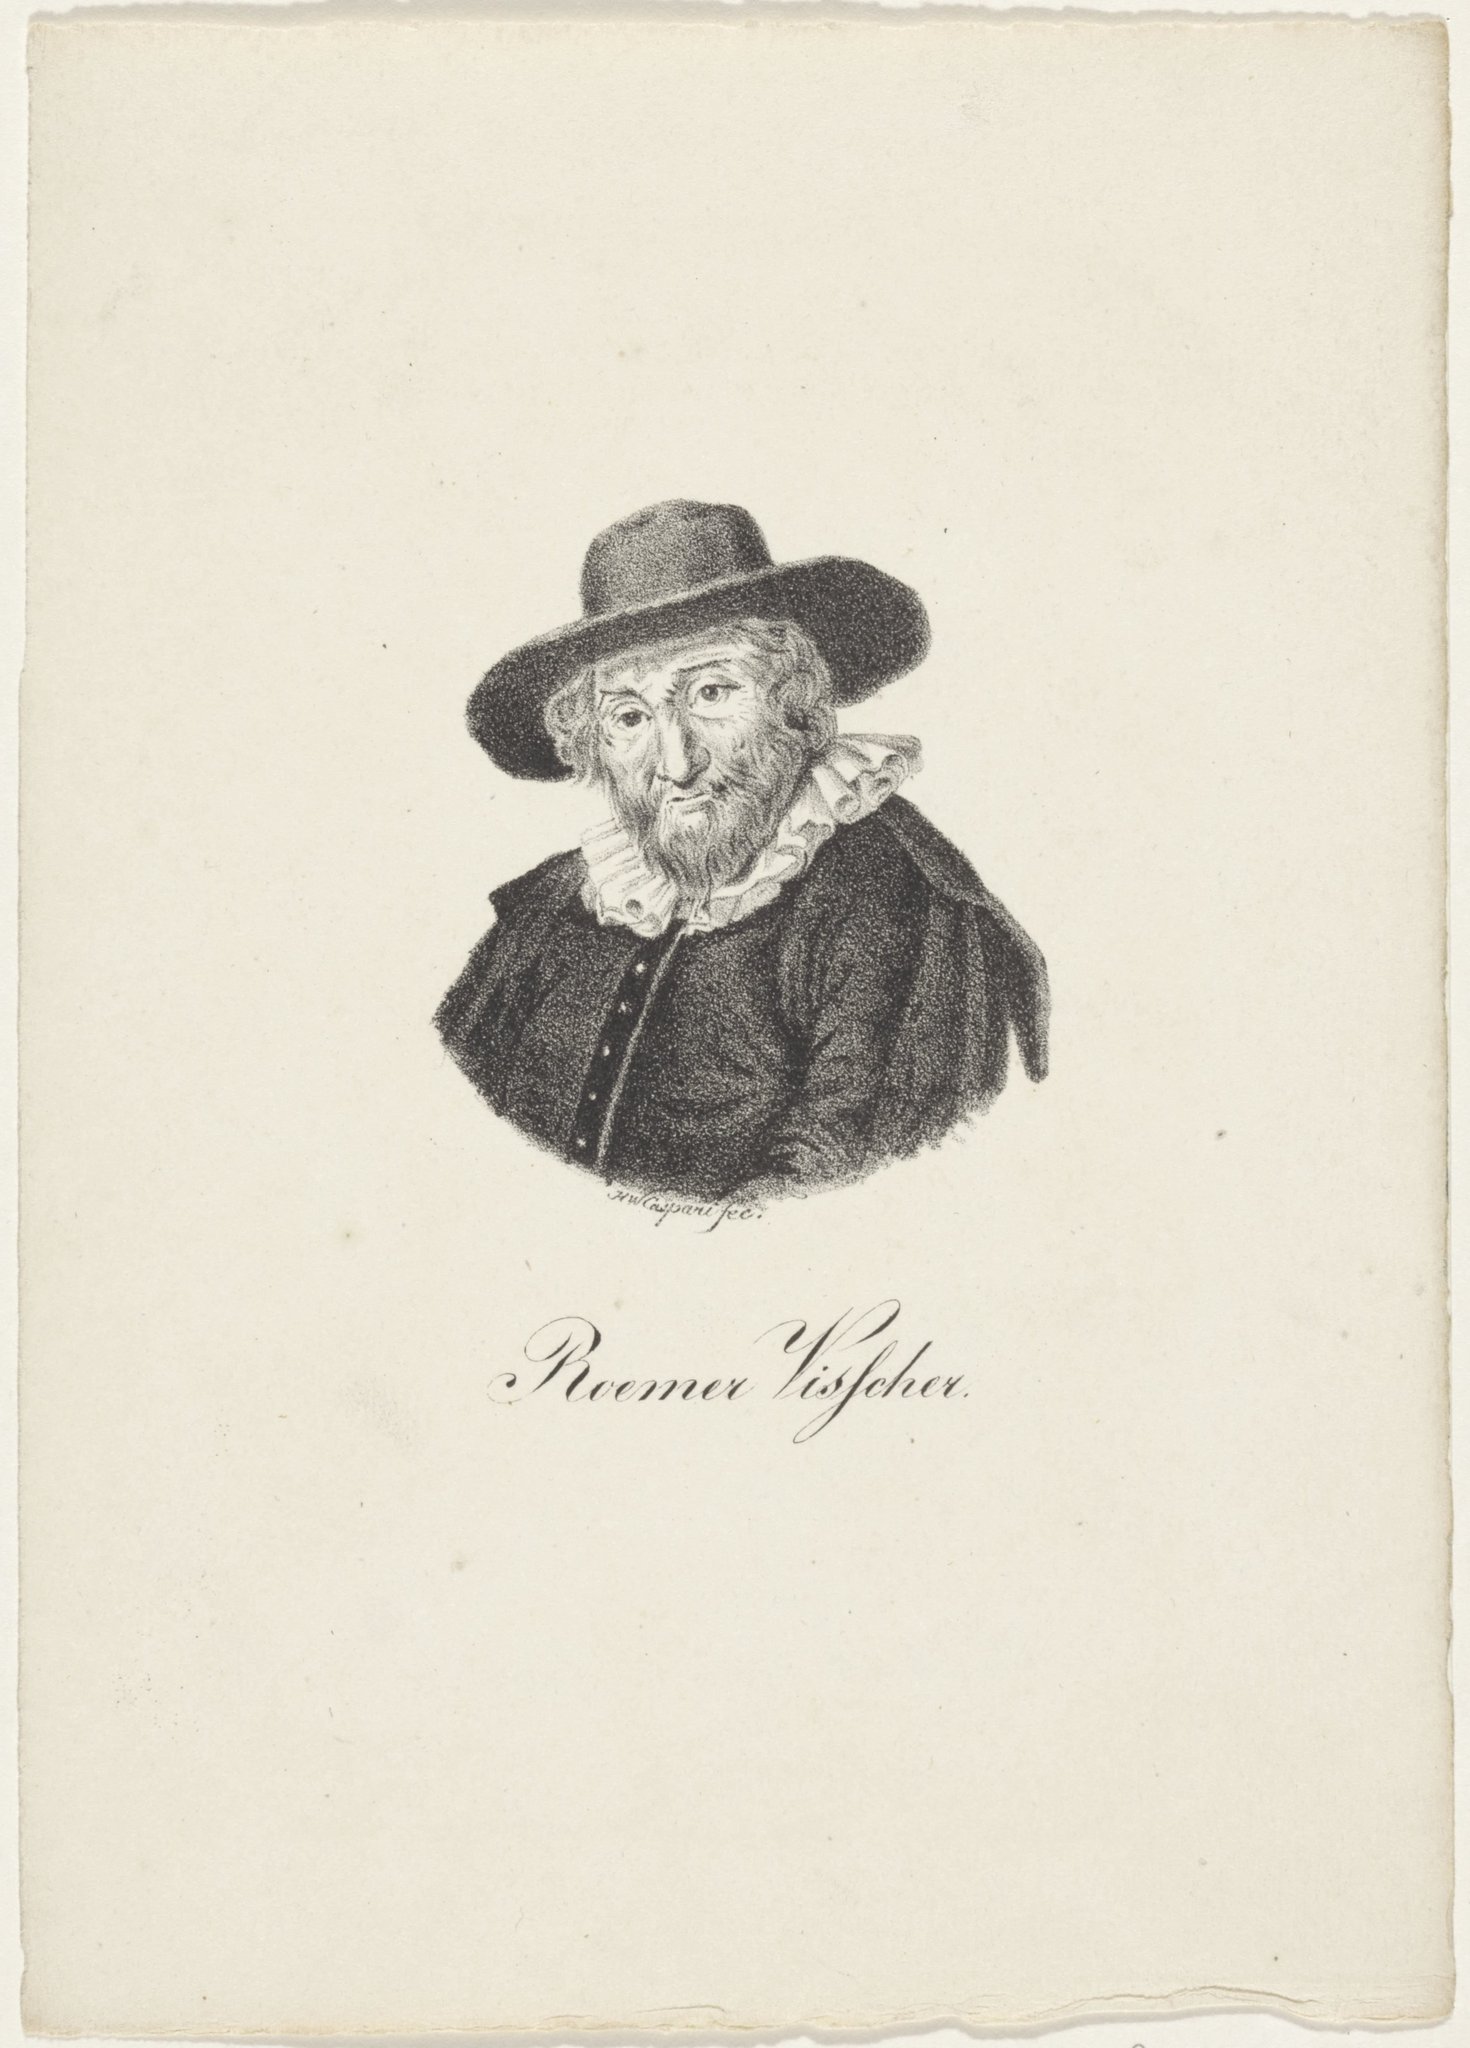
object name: print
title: Portret van Roemer Visscher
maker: hendrik willem caspari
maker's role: draughtsman, print maker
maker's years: 1770-1829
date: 1809-1829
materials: paper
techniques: lithograph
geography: amsterdam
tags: historical persons (+ head (and shoulders) (portrait)), head-gear: hat, neck-gear: collar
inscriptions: collector's mark: Lugt 2760, collector's mark: Lugt 2228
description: De geportretteerde draagt een breedgerande hoed en een plooikraag. Onder het portret zijn naam.